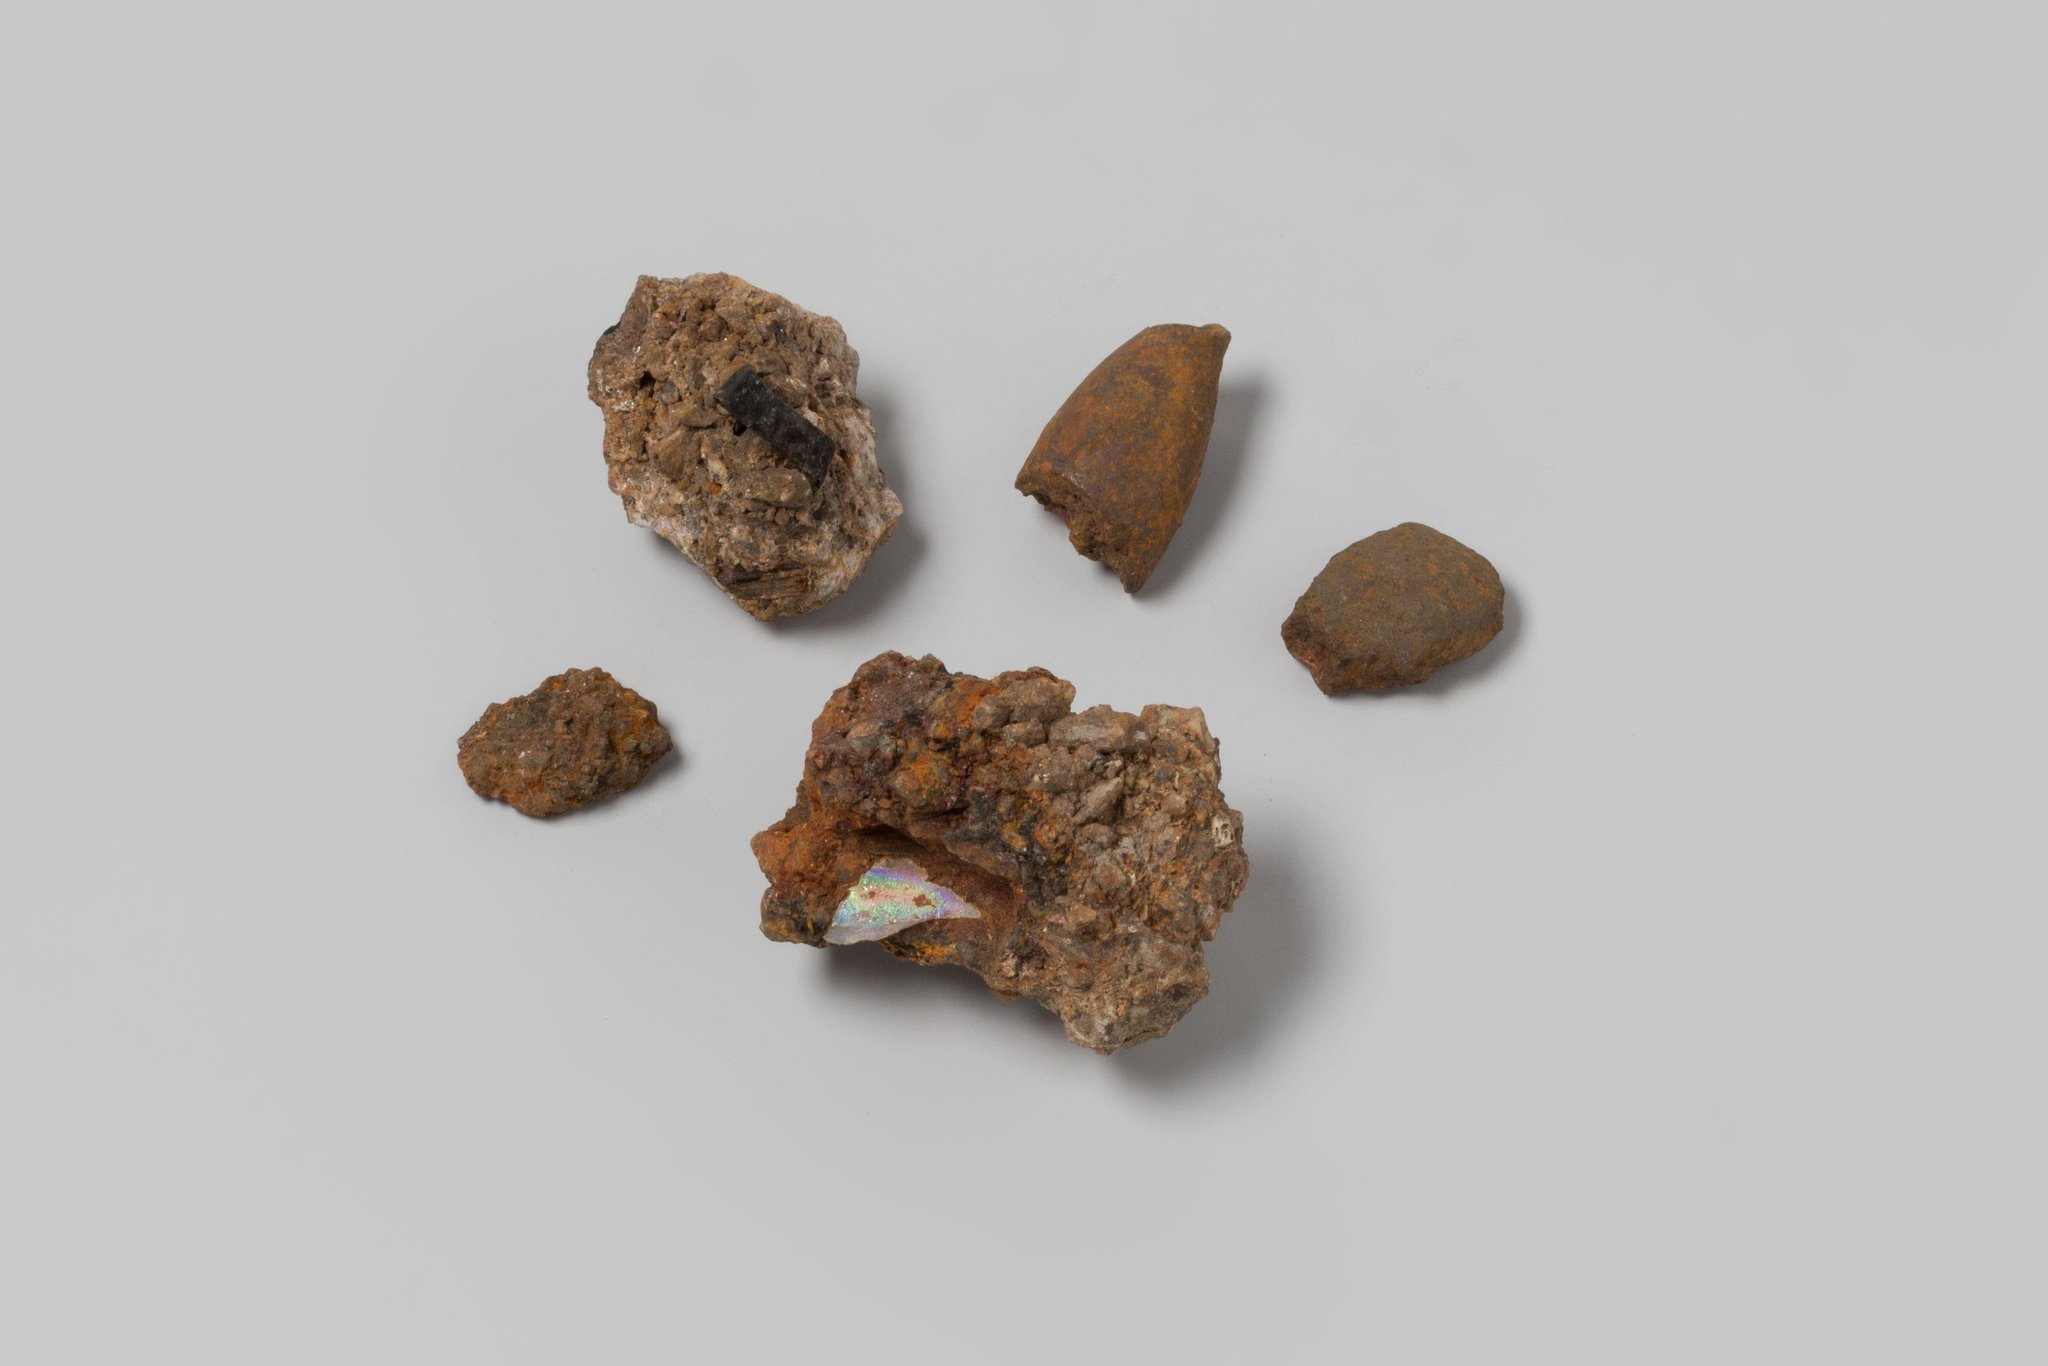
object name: concretionary stone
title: Brokken concretie met fragmenten van glas en ijzer uit het wrak van de Oost-Indiëvaarder Hollandia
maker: Anonymous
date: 1700-1743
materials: stone, glass, iron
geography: netherlands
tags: verenigde oostindische compagnie, hollandia (schip), annet